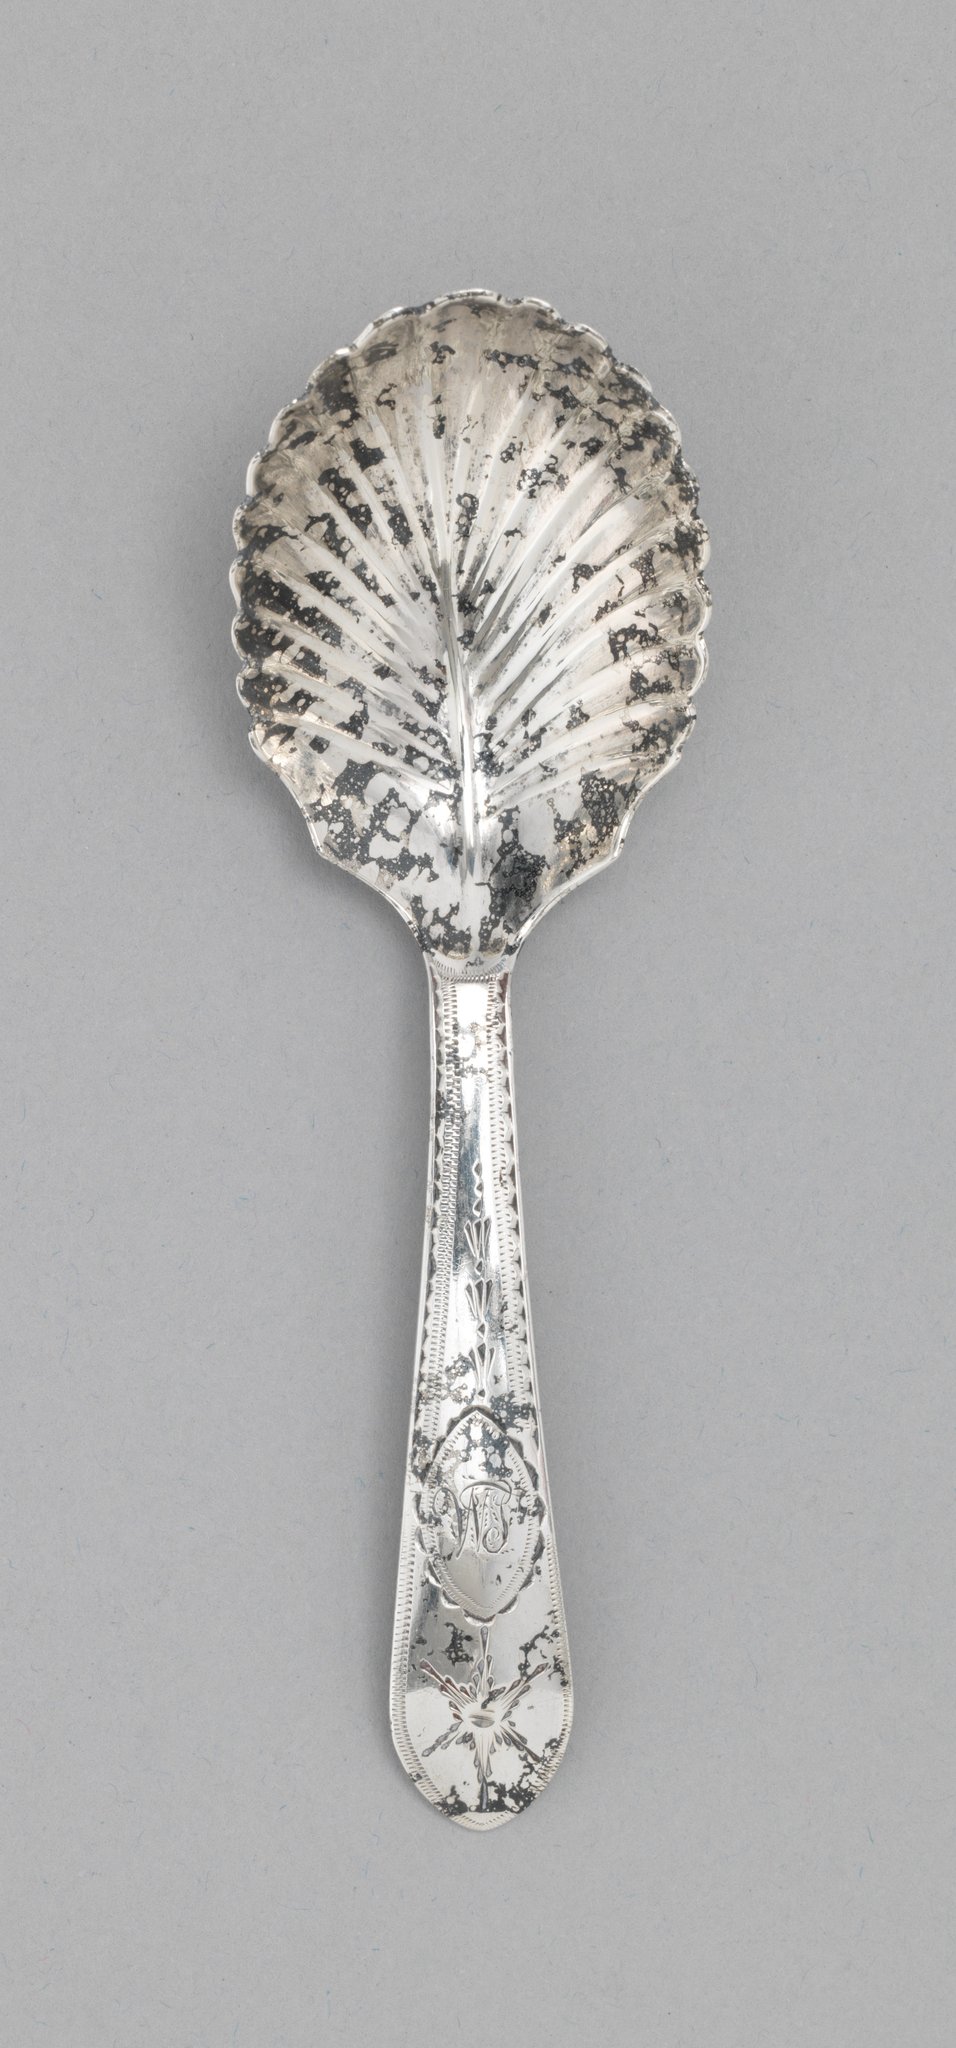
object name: tea caddy with spoon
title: Tea caddy spoon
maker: william hamey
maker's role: maker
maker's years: 1765-1812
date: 1801-1833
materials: silver